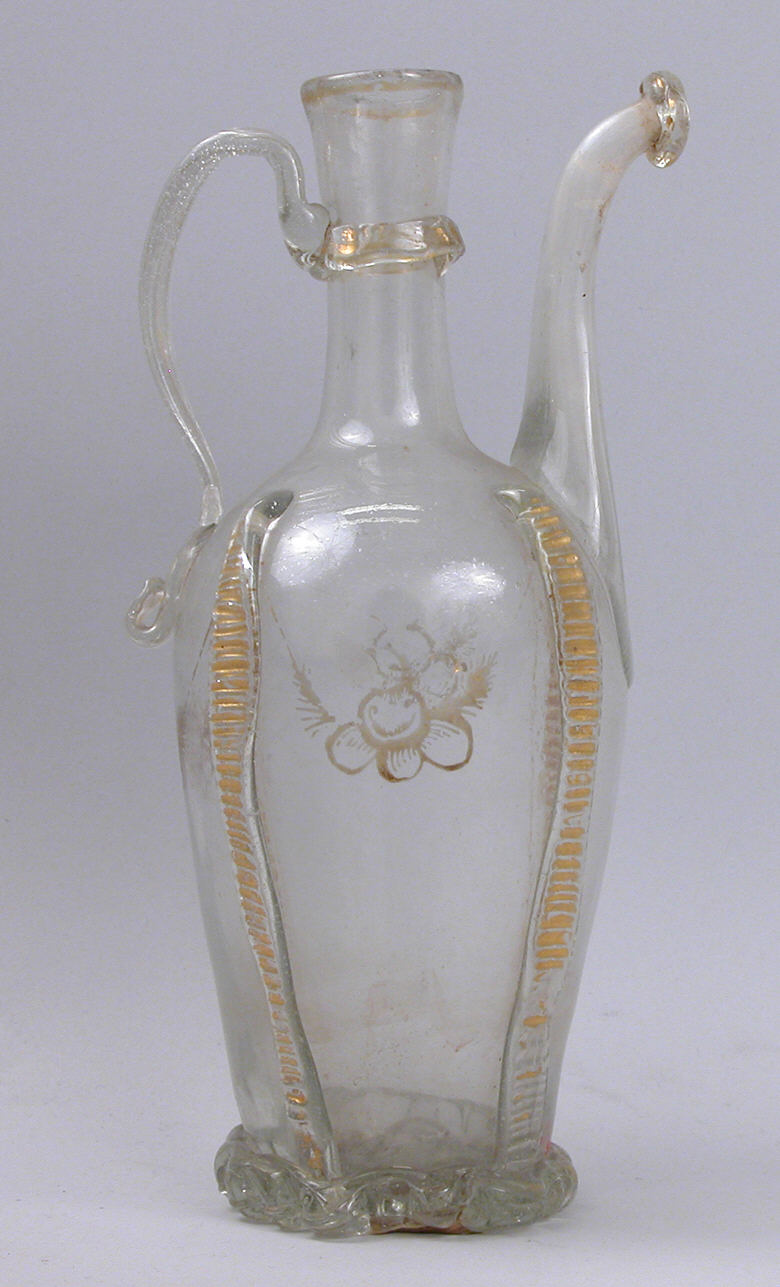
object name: ewer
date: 1701-1900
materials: glass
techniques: painting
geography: iran